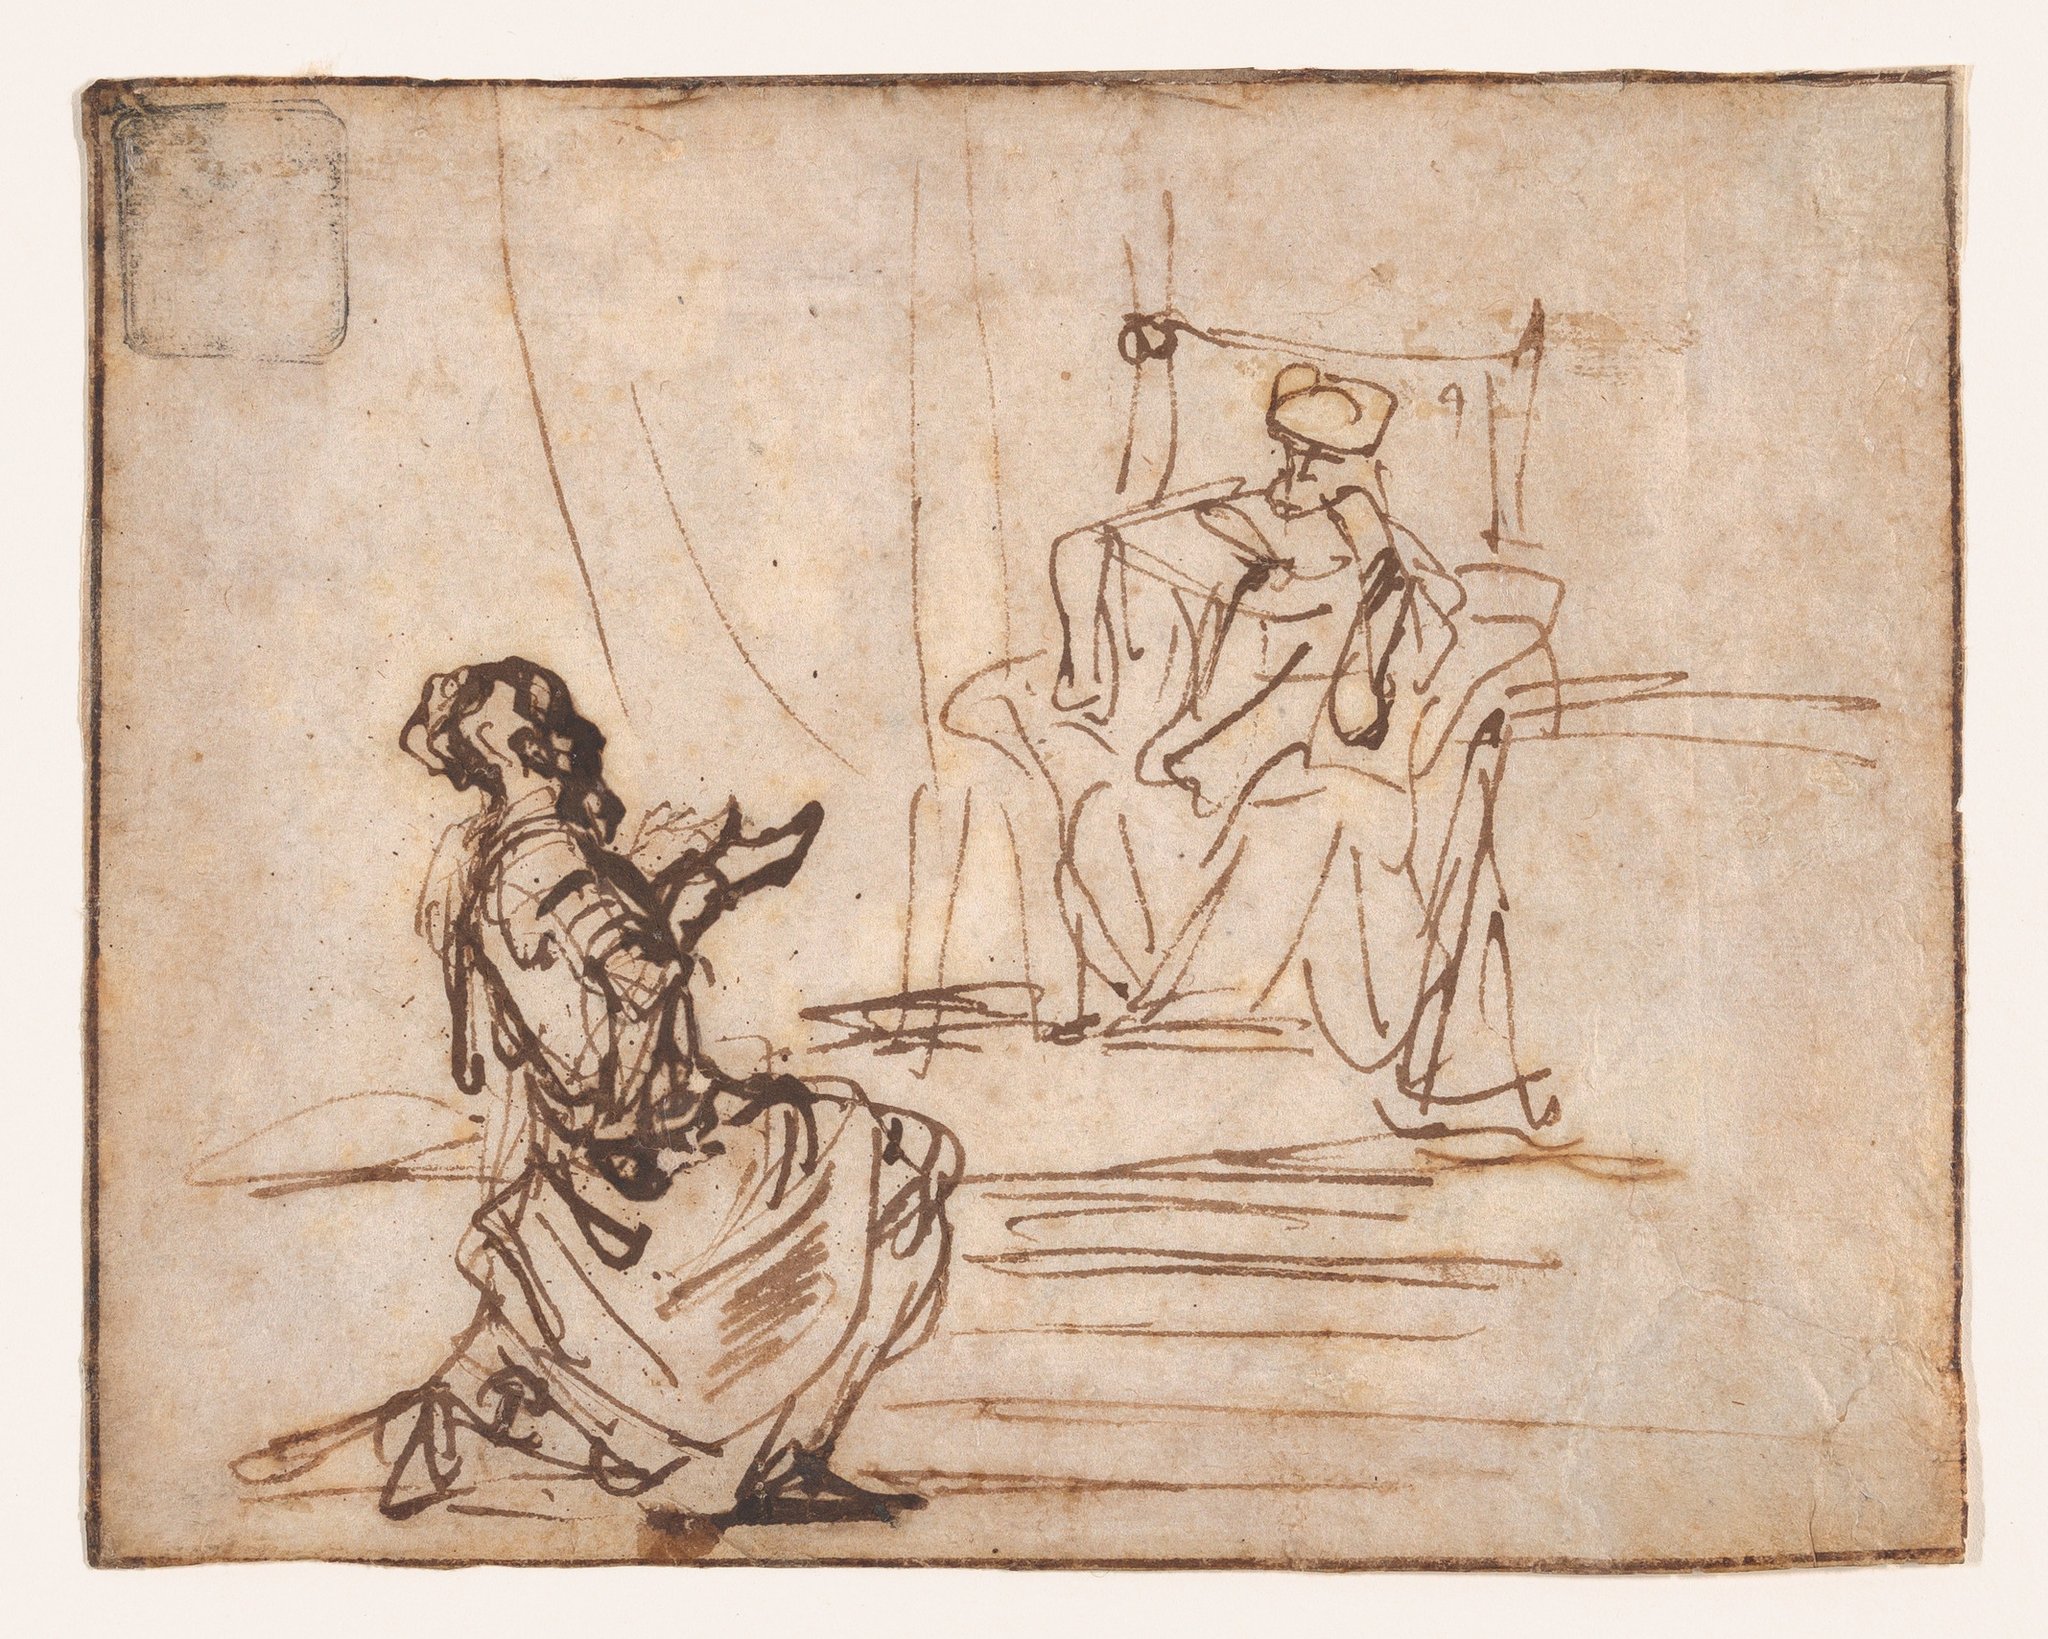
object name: drawing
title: Uriah before King David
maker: gerbrand van den eeckhout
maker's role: artist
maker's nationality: dutch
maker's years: 1621-1674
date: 1601-1700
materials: ink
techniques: pen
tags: kings,men